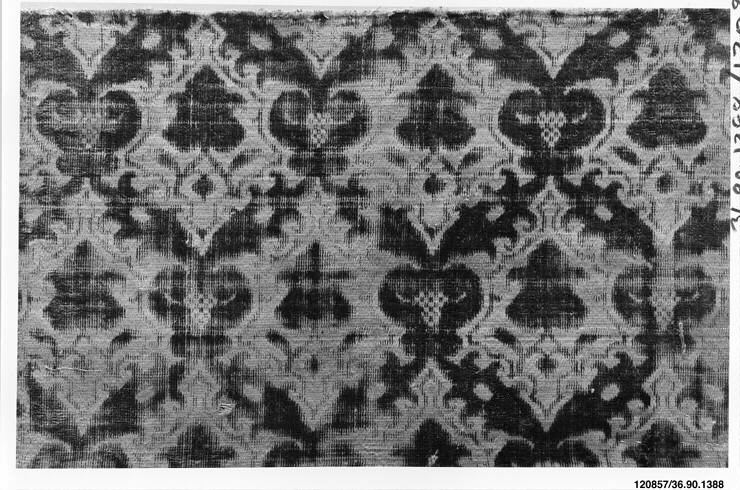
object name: piece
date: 1501-1600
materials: silk